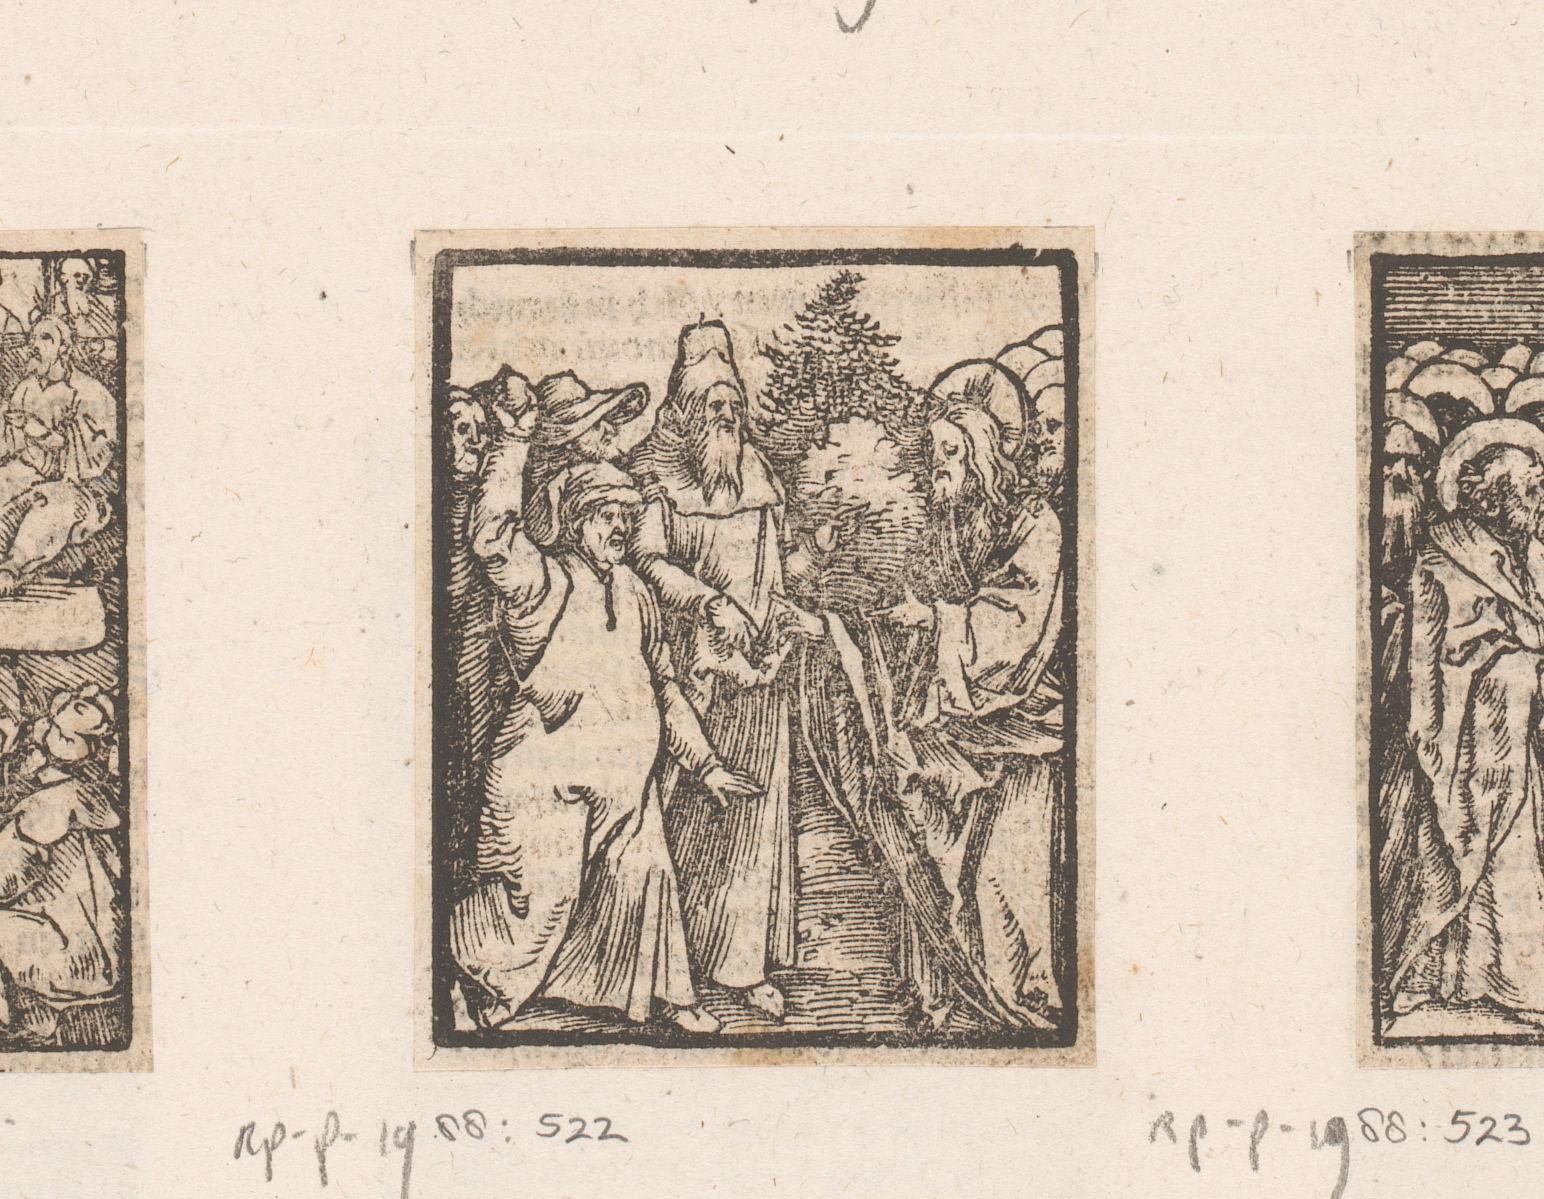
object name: book illustration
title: Christus sprekend met de Joden die hem willen stenigen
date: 1536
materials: paper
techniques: woodcut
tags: attempts to stone christ (john 8:59, 10:31-33)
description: Prent afkomstig uit: Evangelia und Epistel. Neurenberg: Hans Guldenmund, 1536.